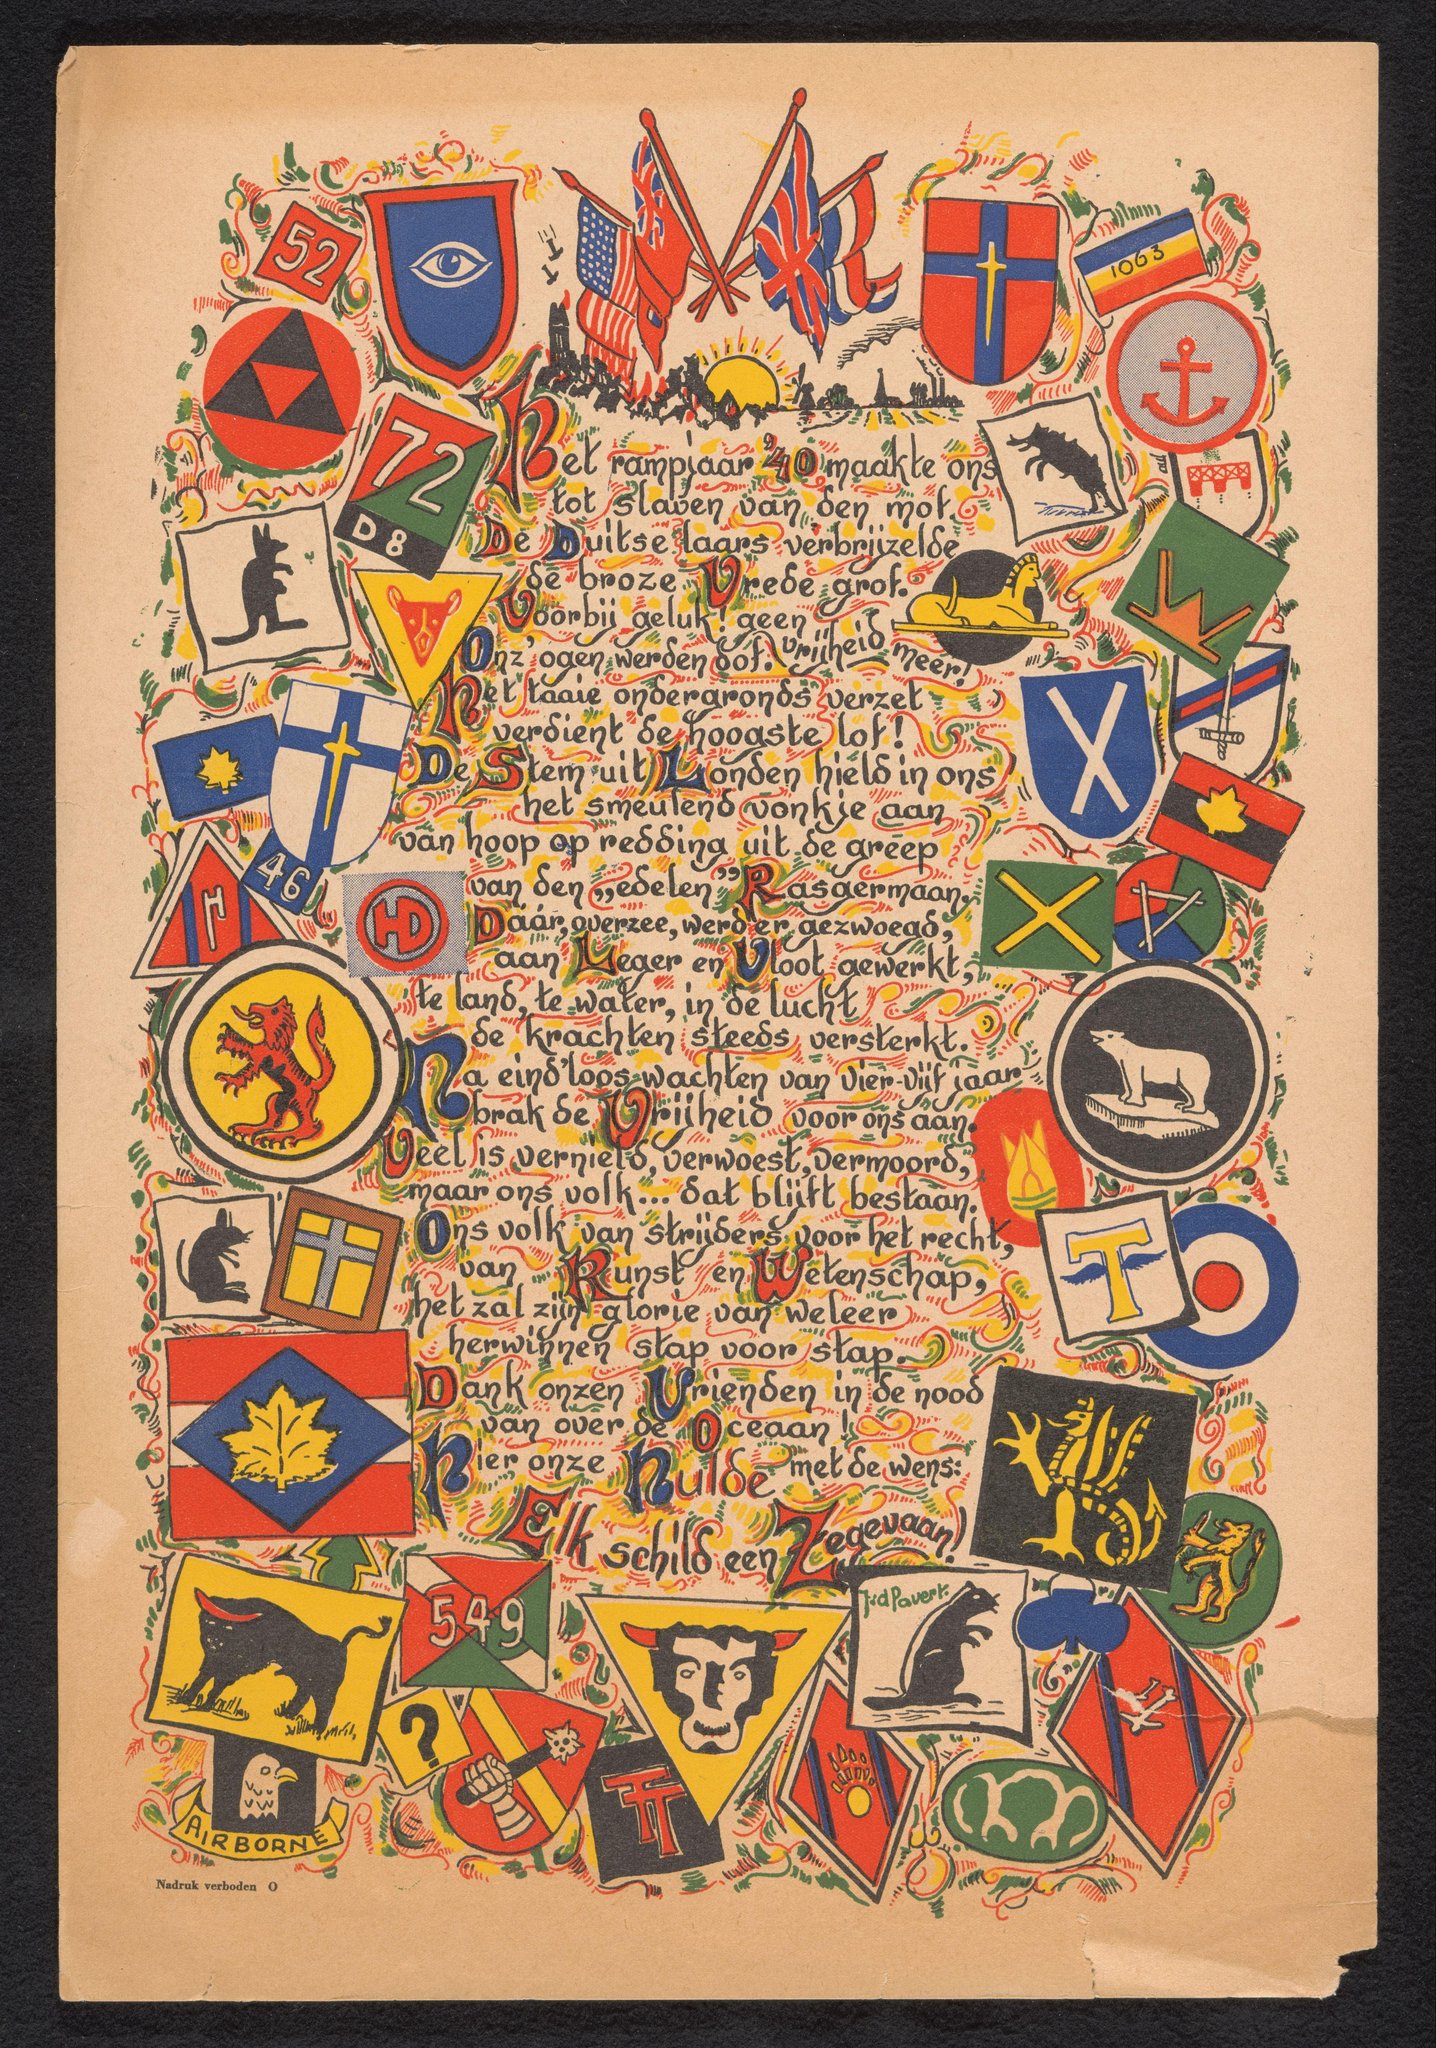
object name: print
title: Victory of Europe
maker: j. v.d. pavert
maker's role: print maker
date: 1945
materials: cardboard, paper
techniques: printing, writing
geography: netherlands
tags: insignia of companies, etc., netherlands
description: Prent. Meerkleurendruk, 'handgeschreven' gedicht met daaromheen en aantal schots en scheef naast en onder elkaar staande schilden (van geallieerde legereenheden).